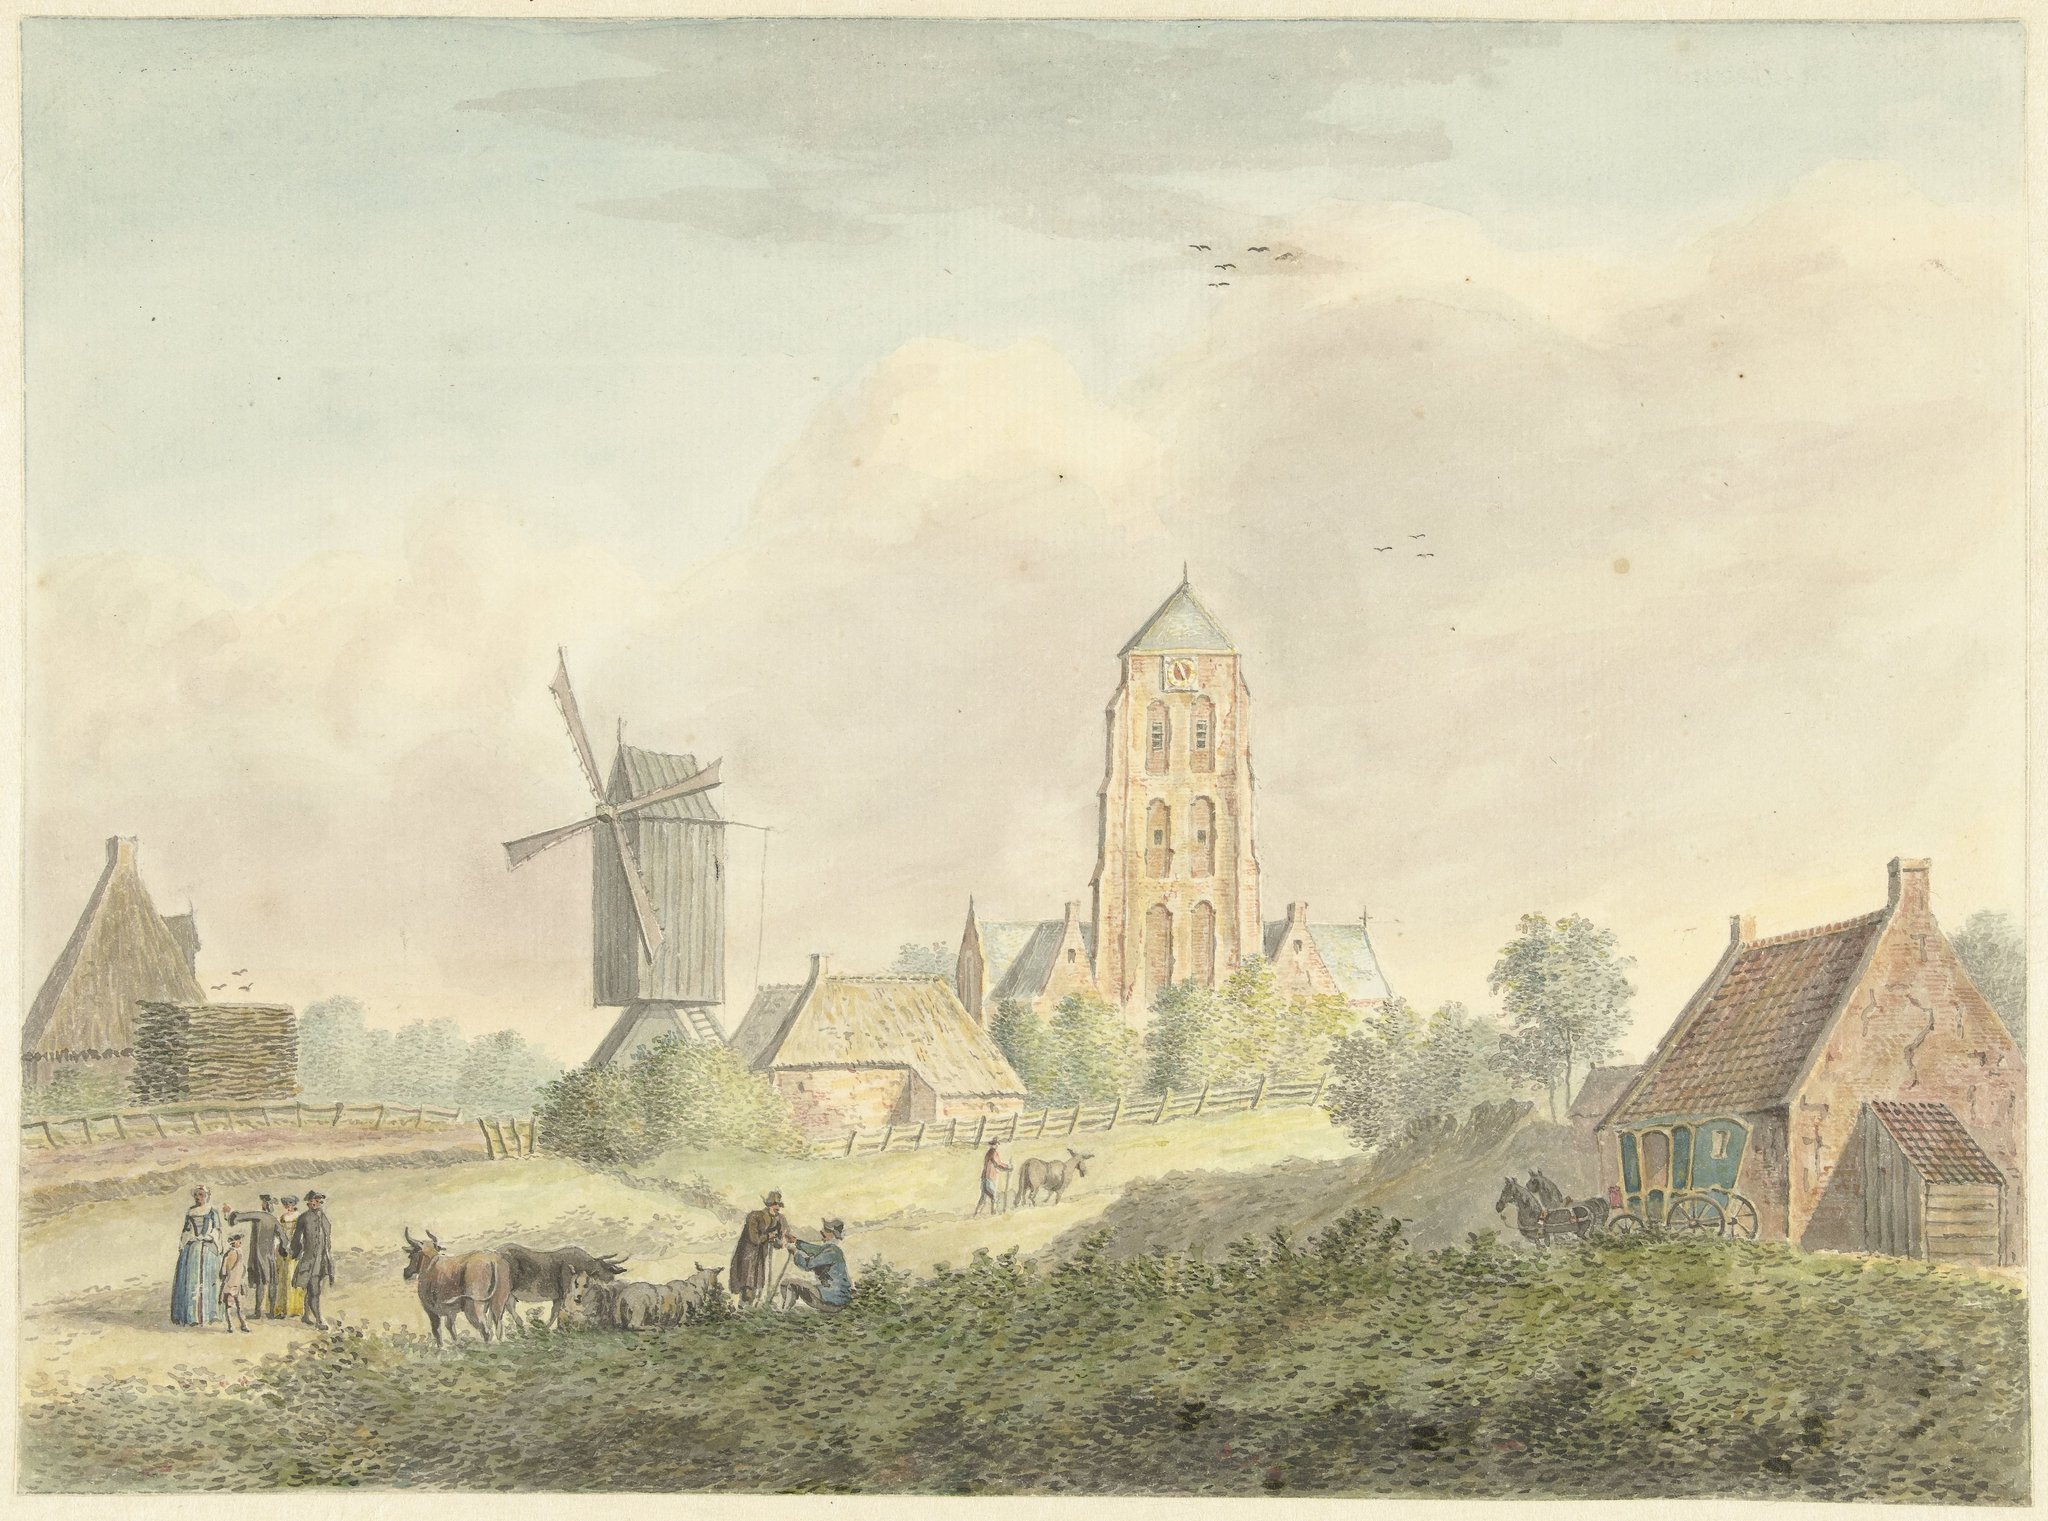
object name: watercolor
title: Kerk van het dorp Westkapelle in Zeeland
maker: hermanus petrus schouten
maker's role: draughtsman, painter, print maker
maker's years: 1747-1822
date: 1757-1822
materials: paper, watercolor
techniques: brush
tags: village, church (exterior), windmill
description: De kerk van het dorp Westkapelle in Zeeland, van de dijk af gezien; op de voorgrond een molen.